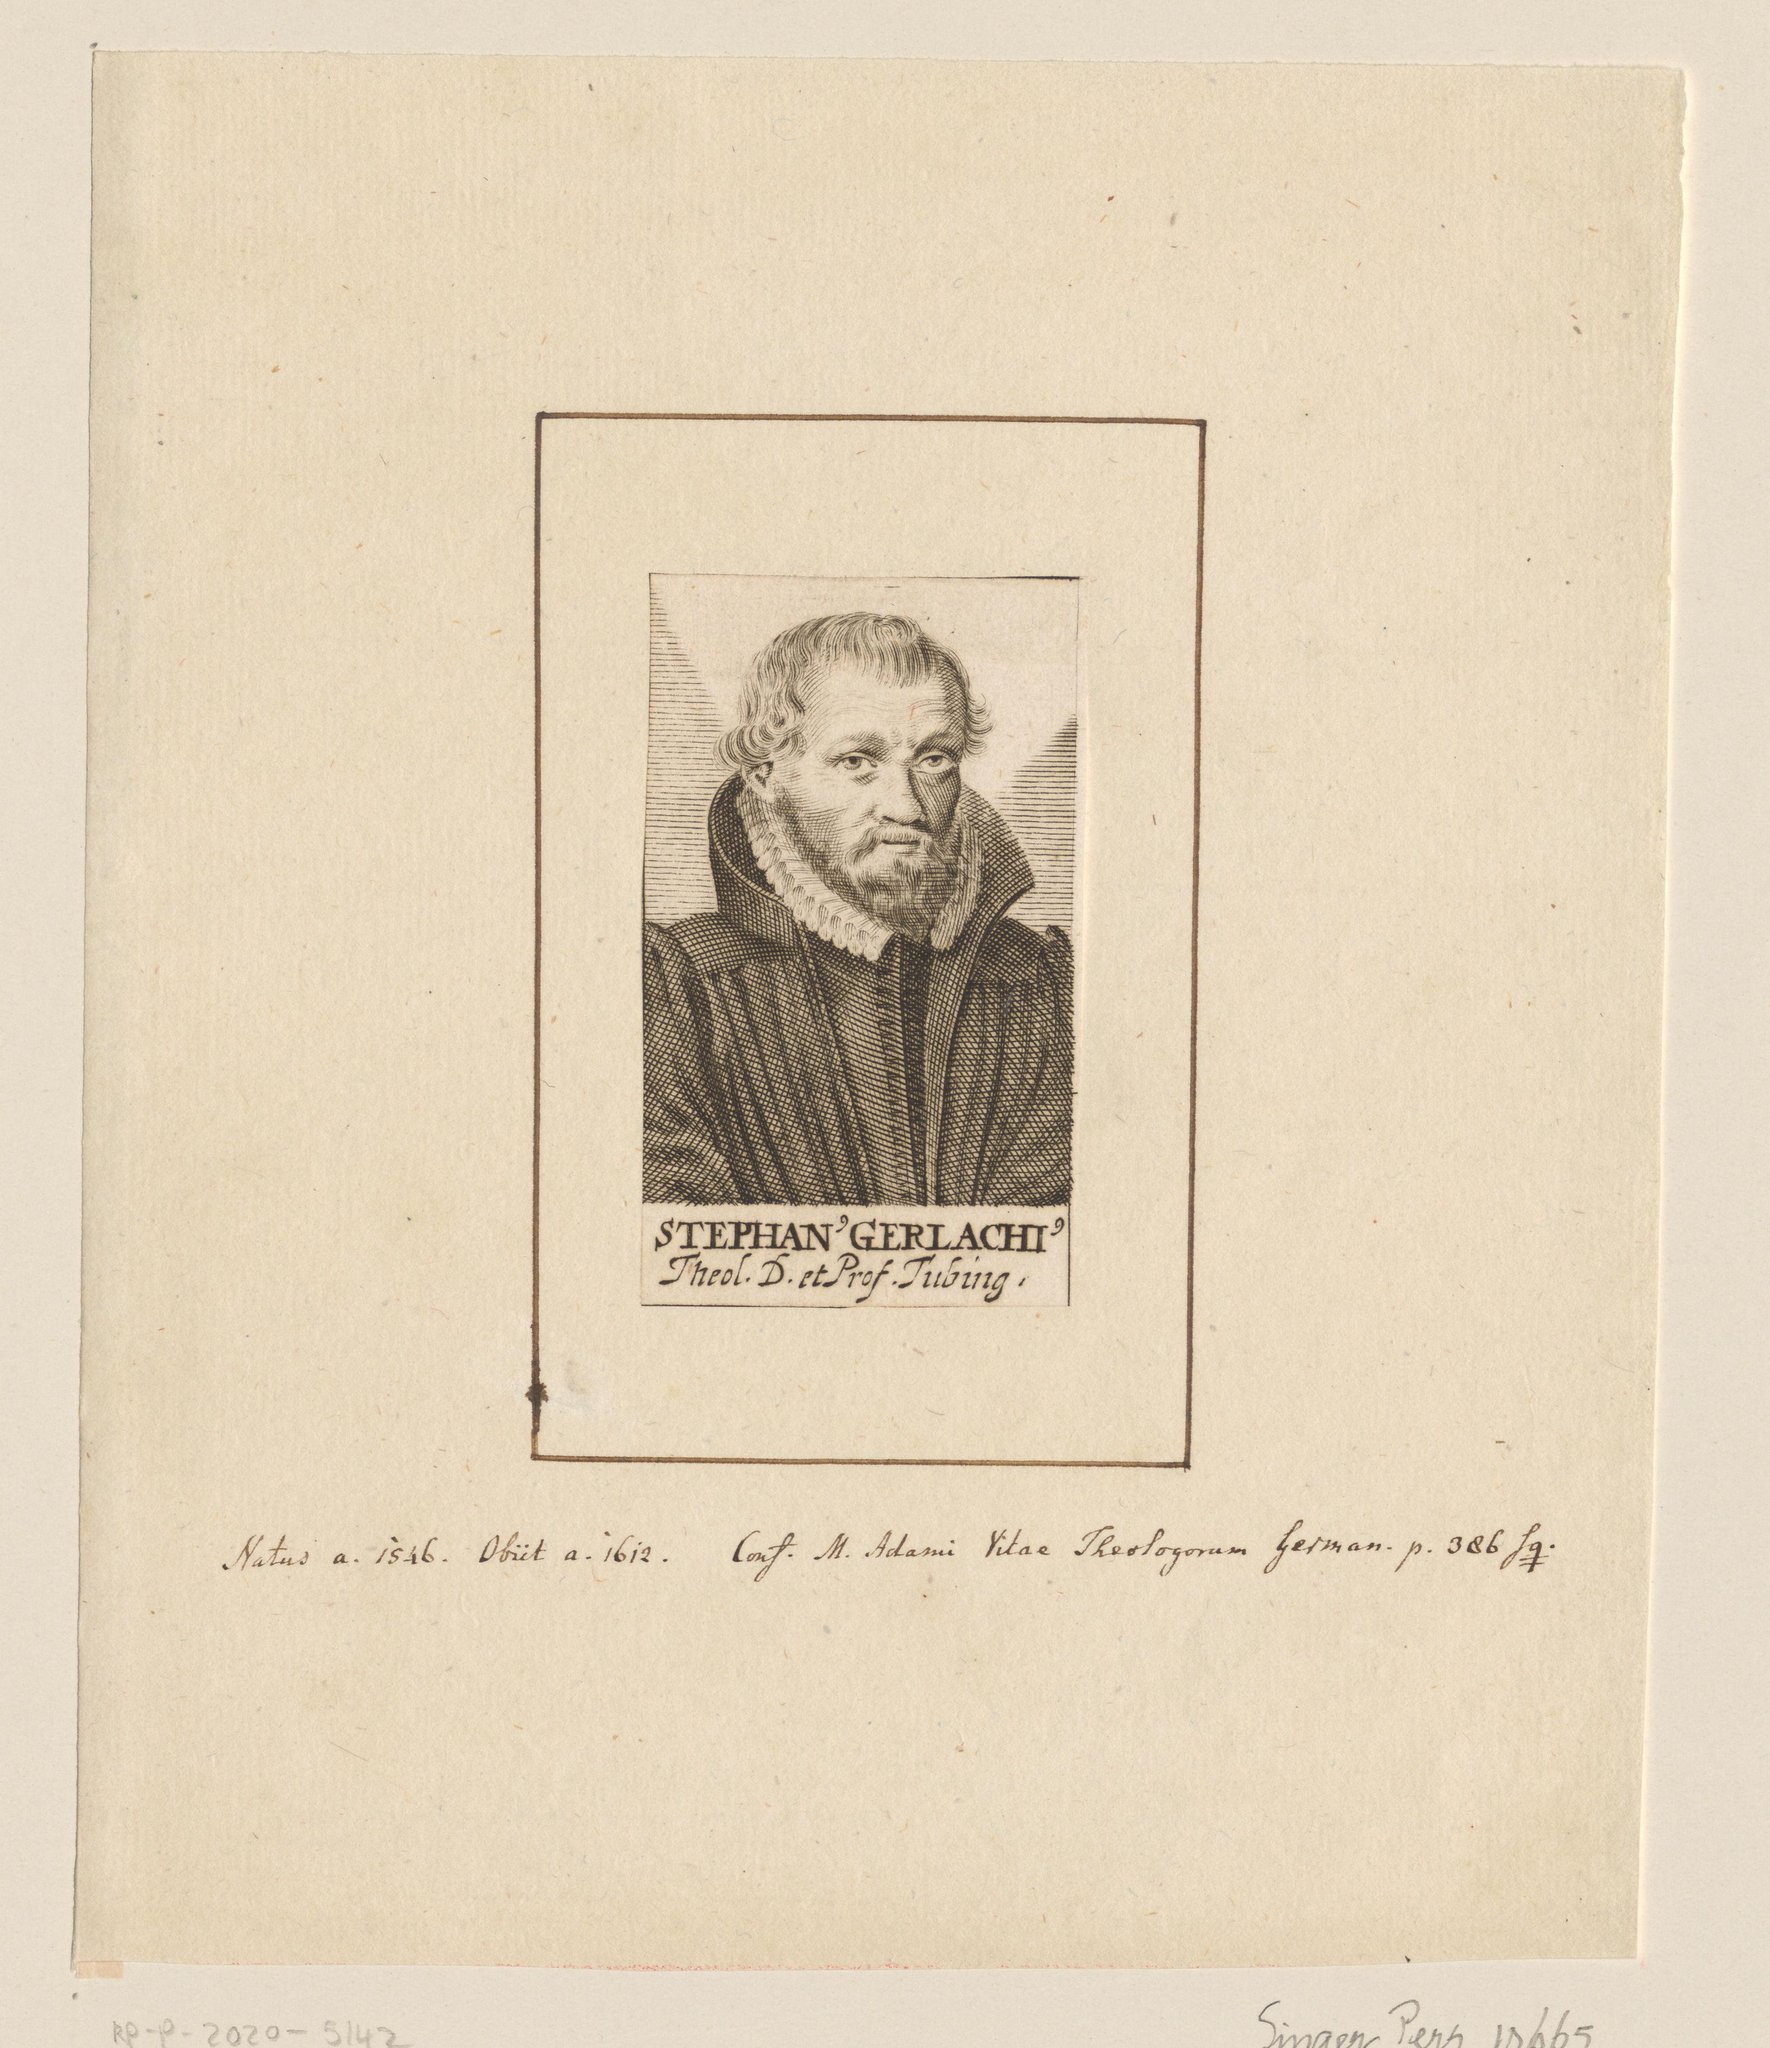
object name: print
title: Portret van Stephan Gerlach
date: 1688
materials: paper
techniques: engraving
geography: nuremberg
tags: theologian, historical persons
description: Prent uit: Freher, Paul. Theatrum virorum eruditione clarorum. Neurenberg: Johann Hoffmann, 1688, blad 18.